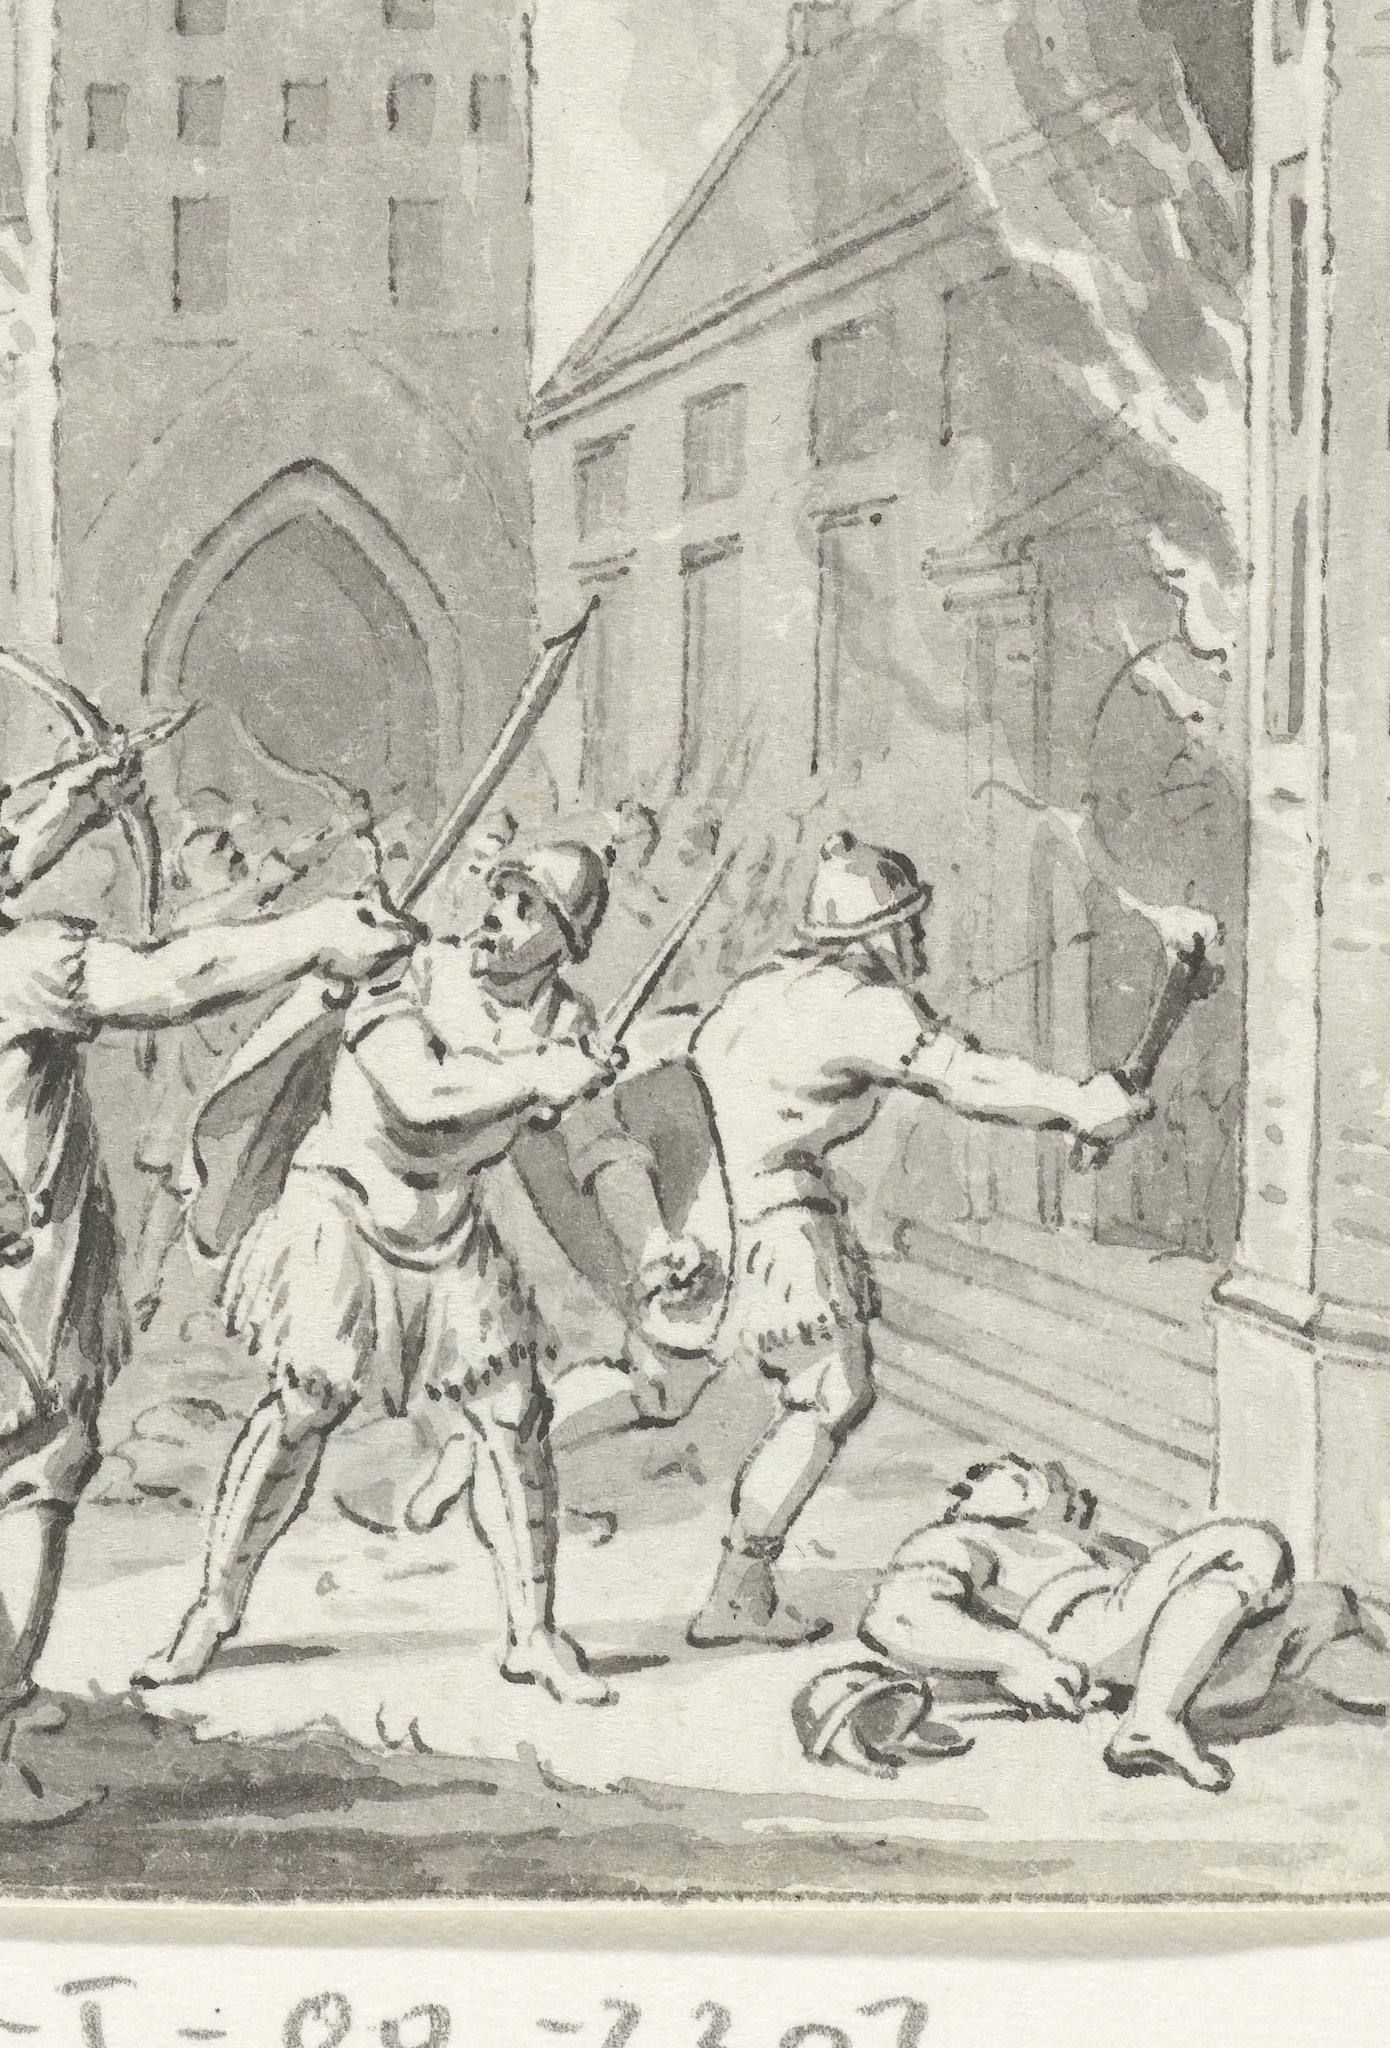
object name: history print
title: De verwoesting van het paleis te Nijmegen door de Noormannen, 881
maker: jacobus buys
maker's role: draughtsman, print maker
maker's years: 1724-1801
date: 1778-1795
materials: ink, paper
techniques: brush, pen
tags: extinct, 'historical' peoples (with name), destruction of conquered city, historical events and situations, nijmegen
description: Ontwerptekening voor illustratie in: J. Fokke, Geschiedenissen der Vereenigde Nederlanden voor de vaderlandsche jeugd, Johannes Allart, Amsterdam 1783-1795, 25 delen.